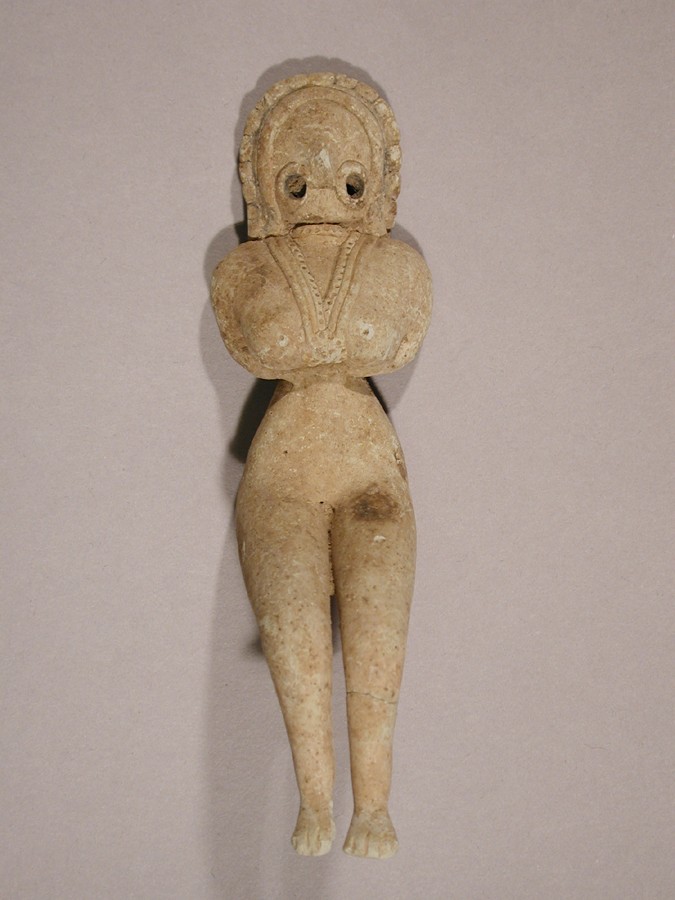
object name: figure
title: Seated Mother Goddess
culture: pakistan, baluchistan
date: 3000-2500 BCE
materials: terracotta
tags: indus valley,goddess